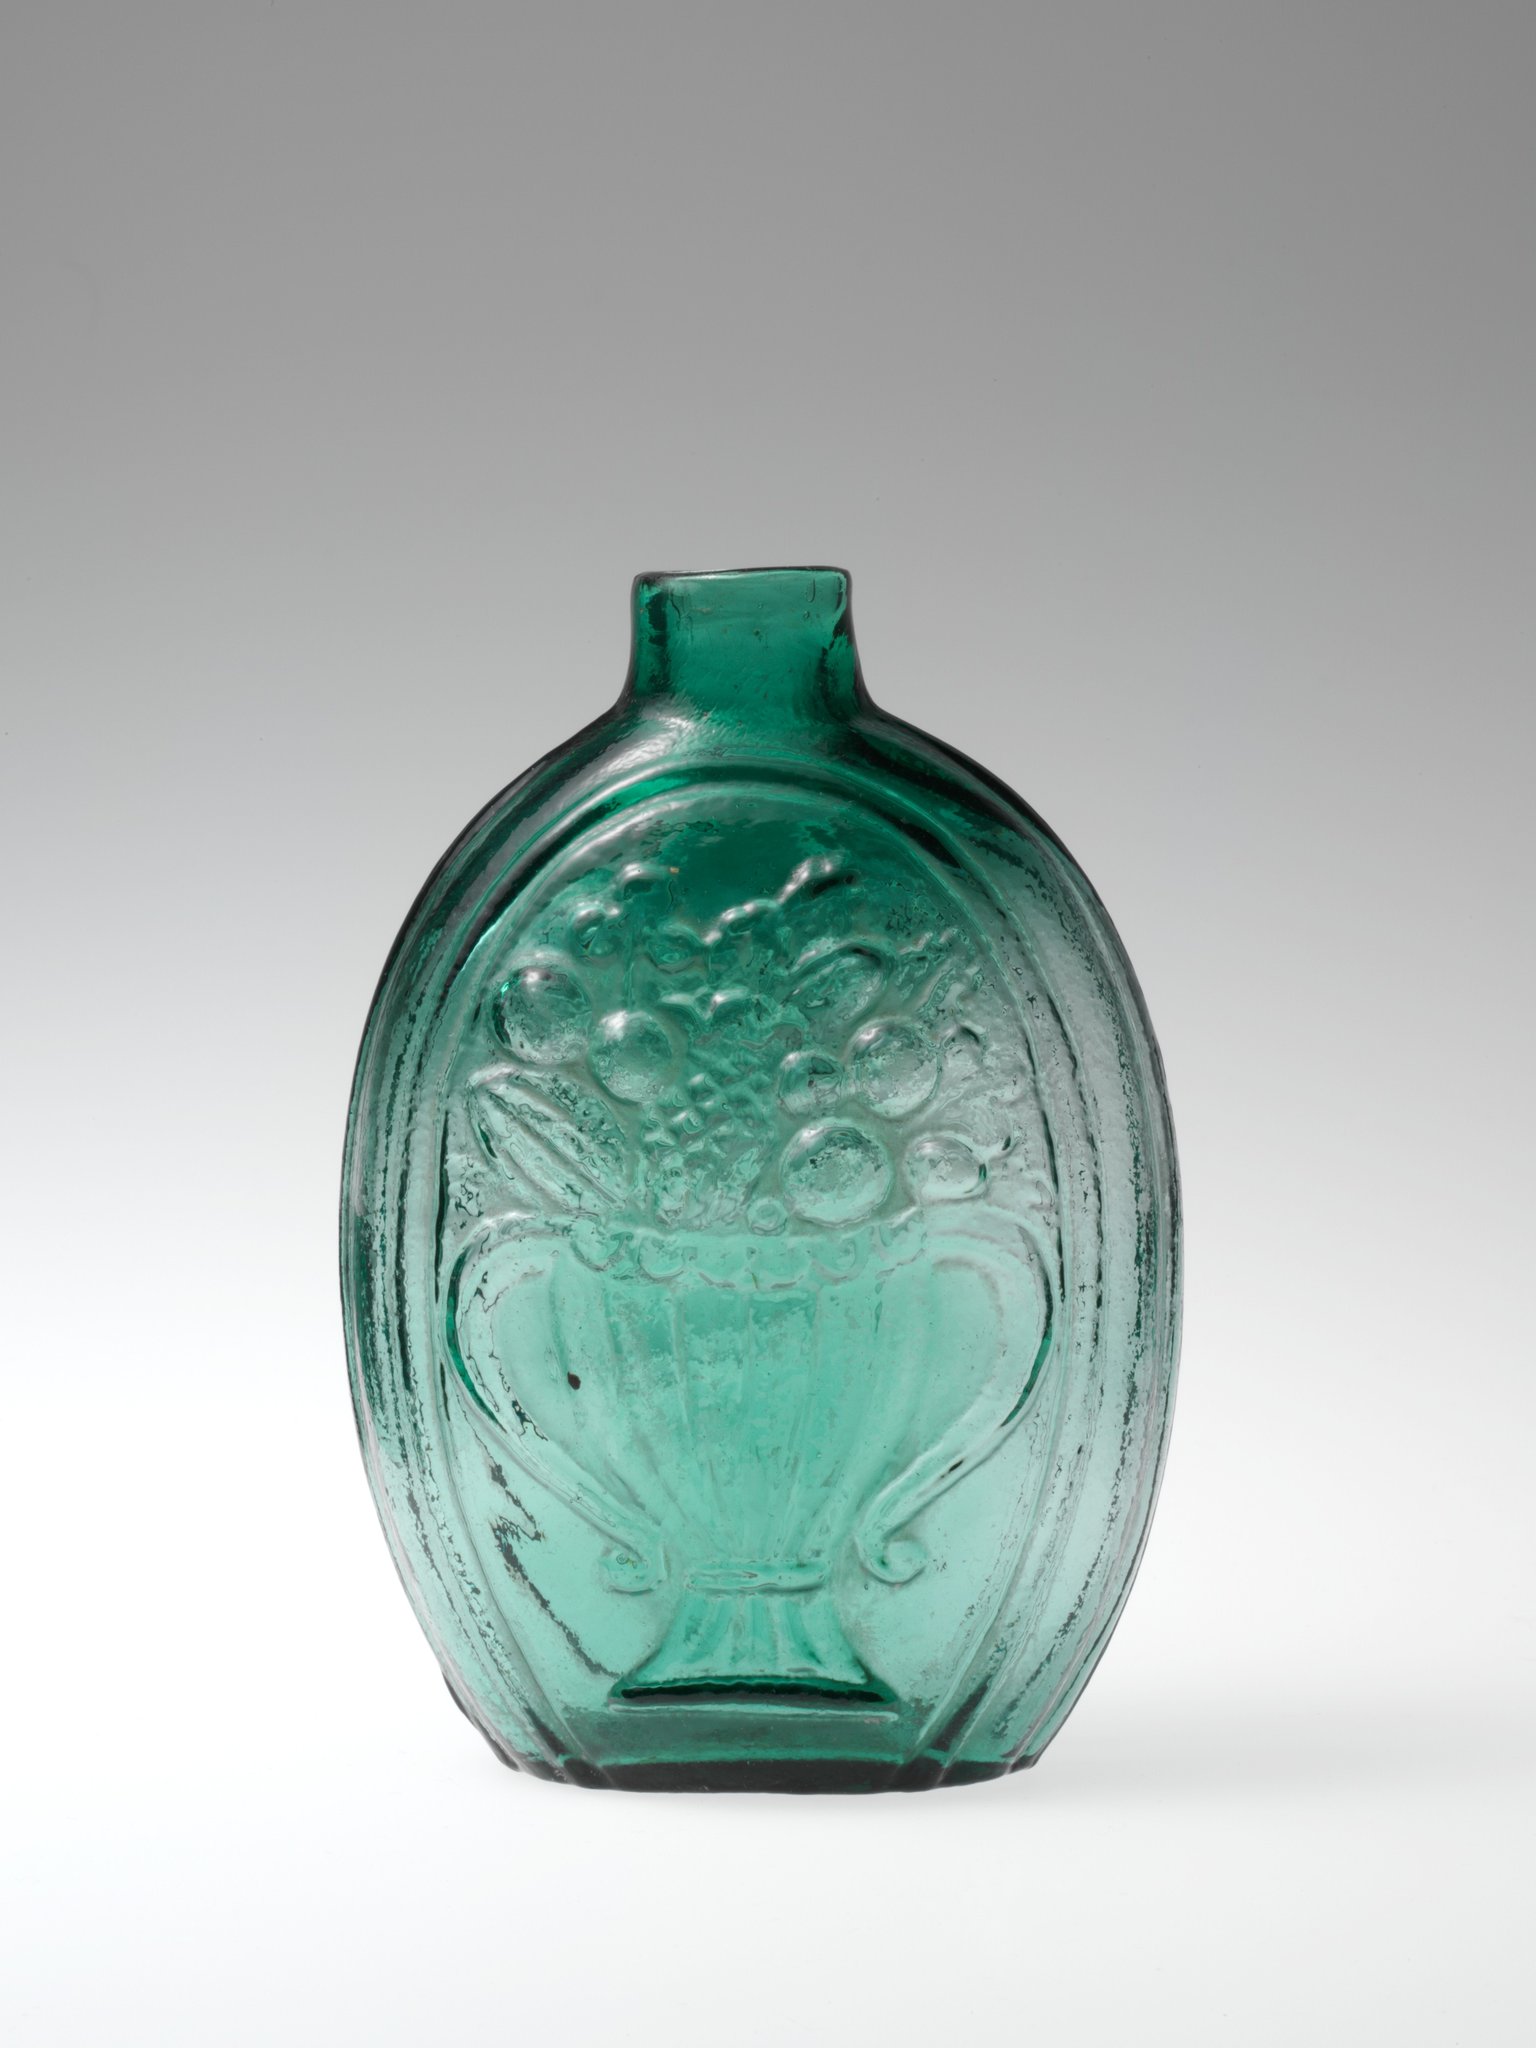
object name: flask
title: Figured flask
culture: american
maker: coventry glass works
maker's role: manufacturer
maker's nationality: american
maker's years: 1813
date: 1824-1840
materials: glass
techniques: glassblowing, molding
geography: united states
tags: fruit